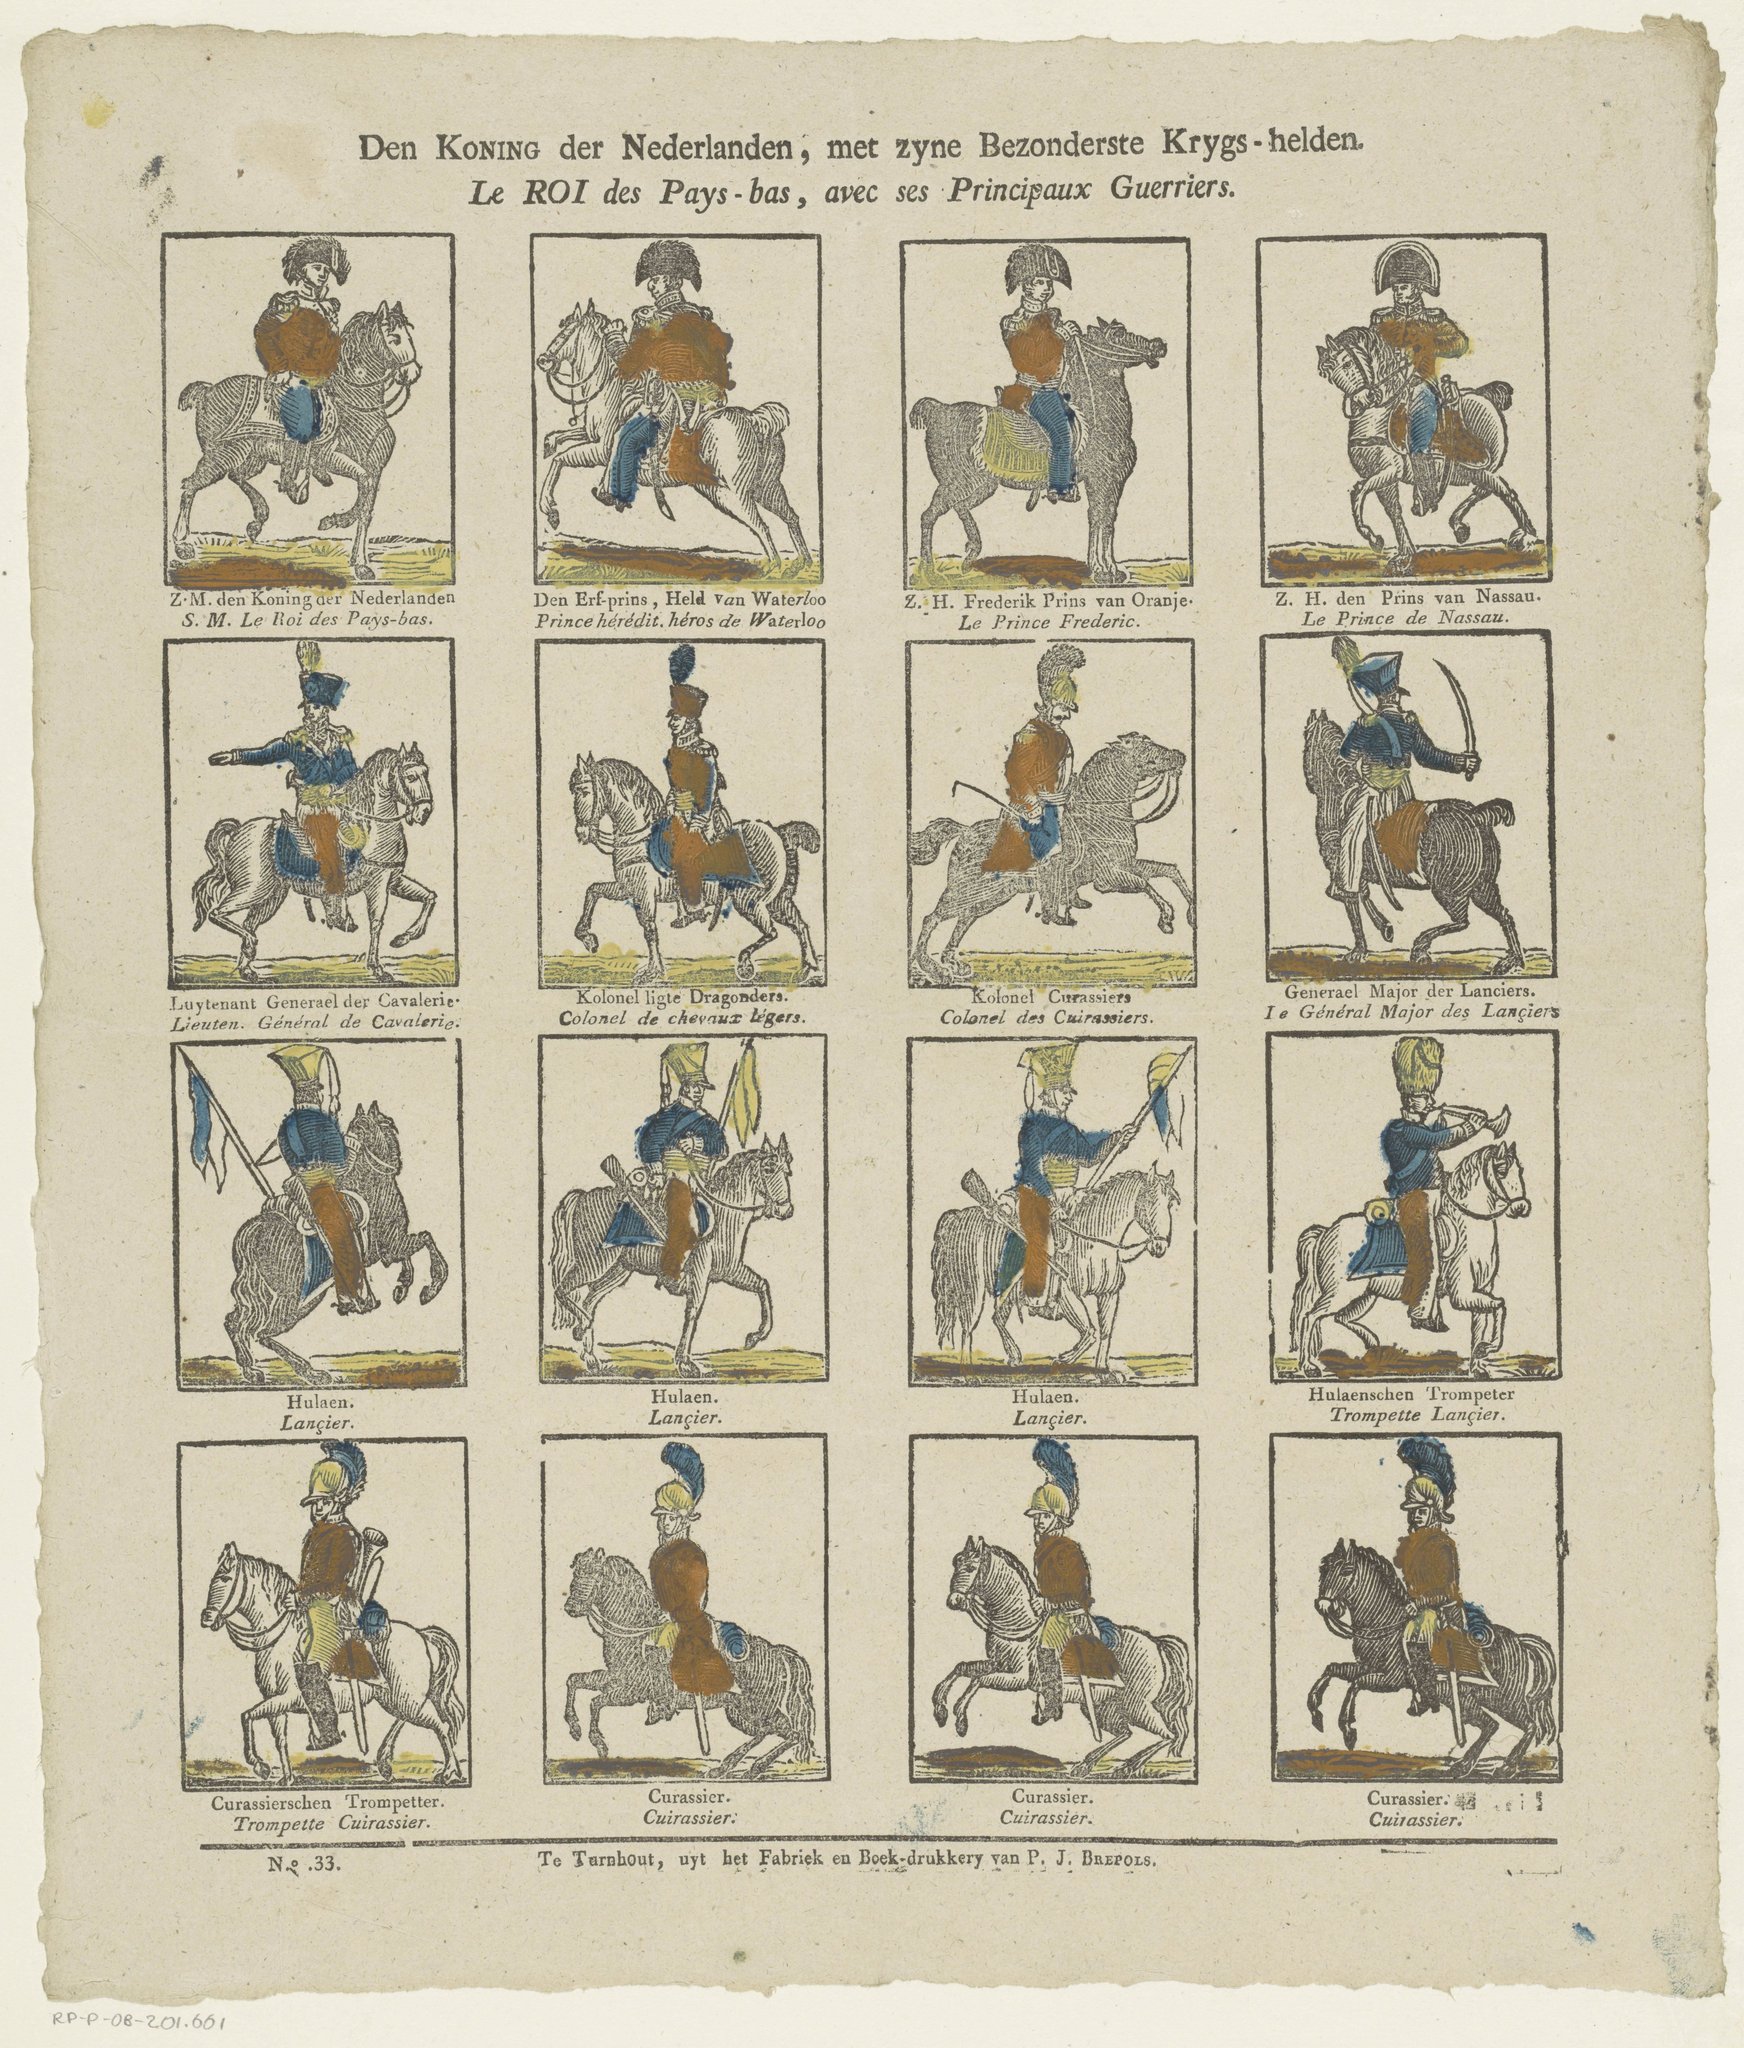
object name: popular print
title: Den koning der Nederlanden, met zyne bezonderste krygs-helden / Le roi de Pays-bas, avec ses principaux guerriers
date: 1800-1833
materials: paper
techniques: colour, letterpress printing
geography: turnhout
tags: berlin, william i of the netherlands, the hague, william ii of the netherlands, warfare; military affairs (+ cavalry, horsemen), the soldier; the soldier's life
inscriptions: collector's mark: Lugt 2760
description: Blad met 16 voorstellingen van koning Willem I en militairen te paard. Onder elke afbeelding een onderschrift in het Nederlands en in het Frans. Genummerd linksonder: No. 33.